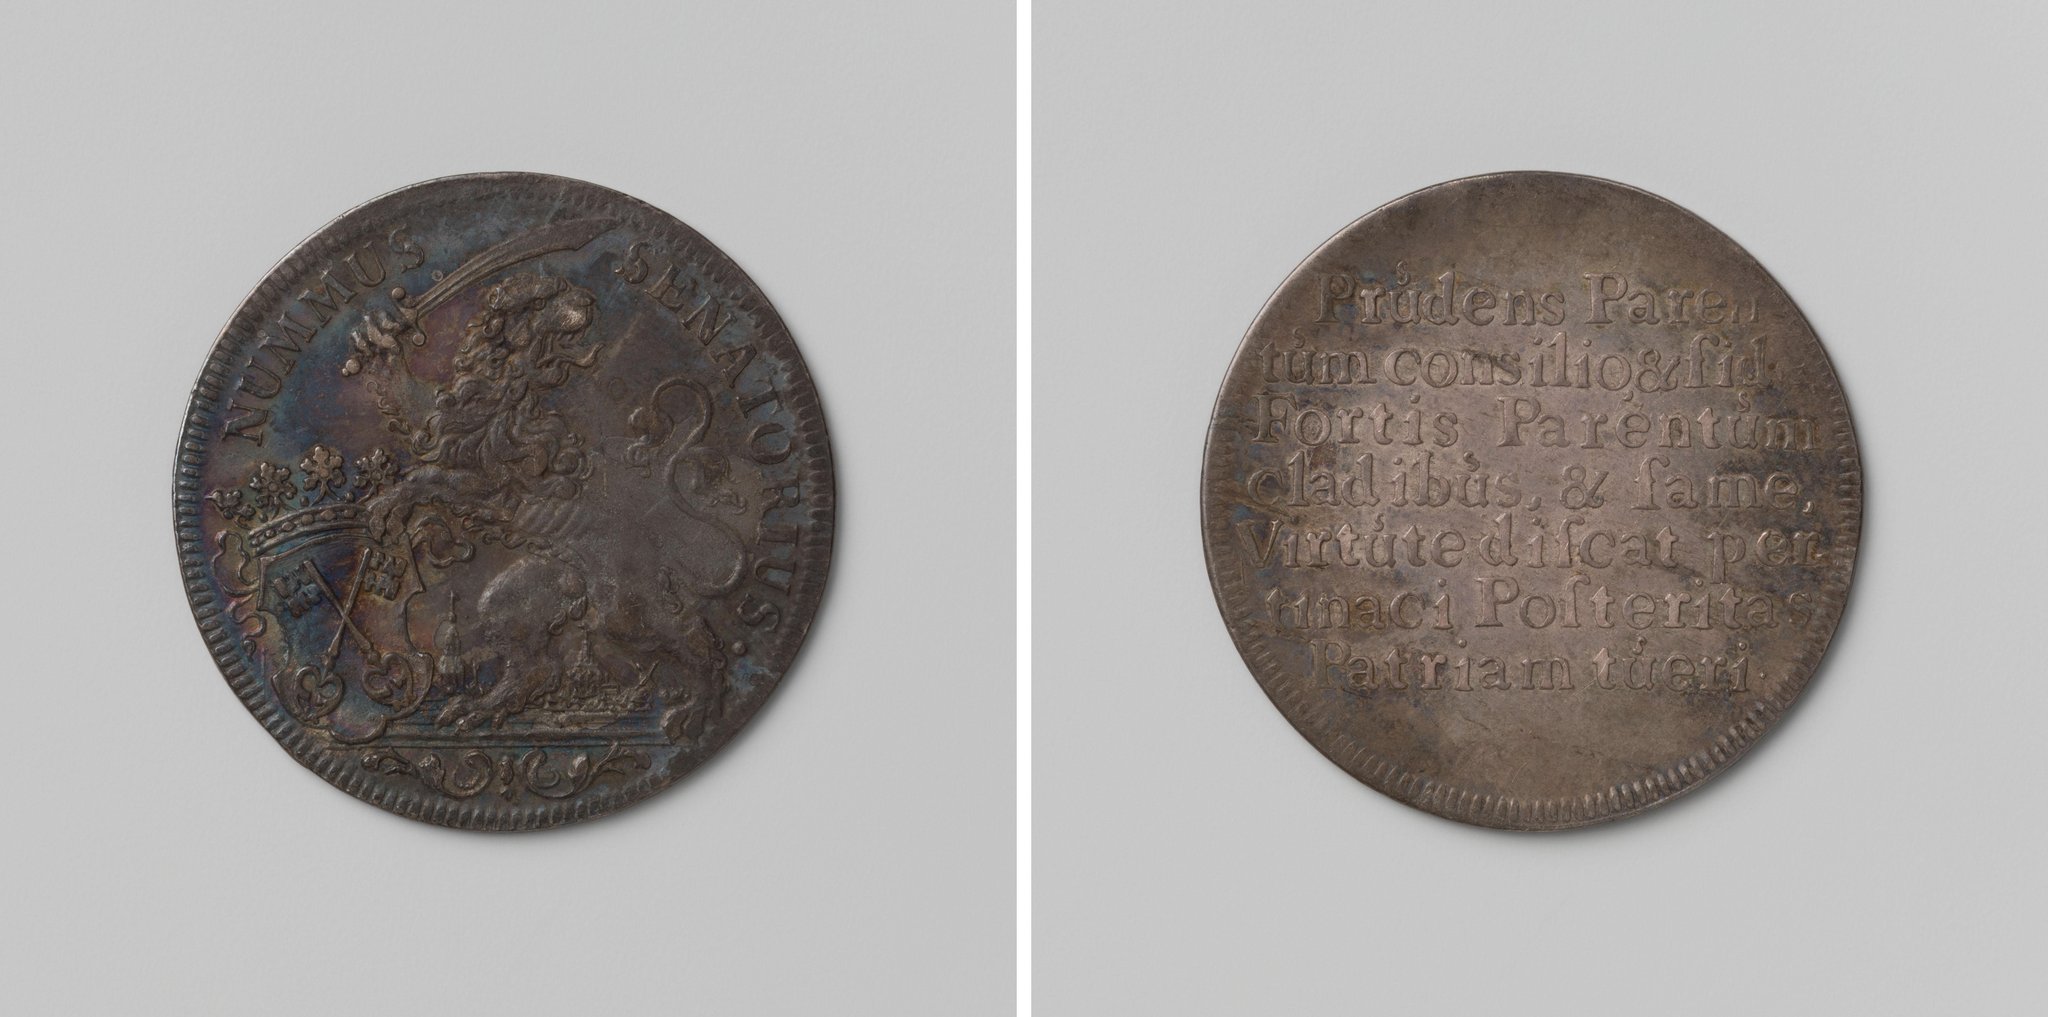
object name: council medal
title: Vroedschapspenning van de stad Leiden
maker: Anonymous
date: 1671-1723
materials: silver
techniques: striking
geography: leiden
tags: leiden